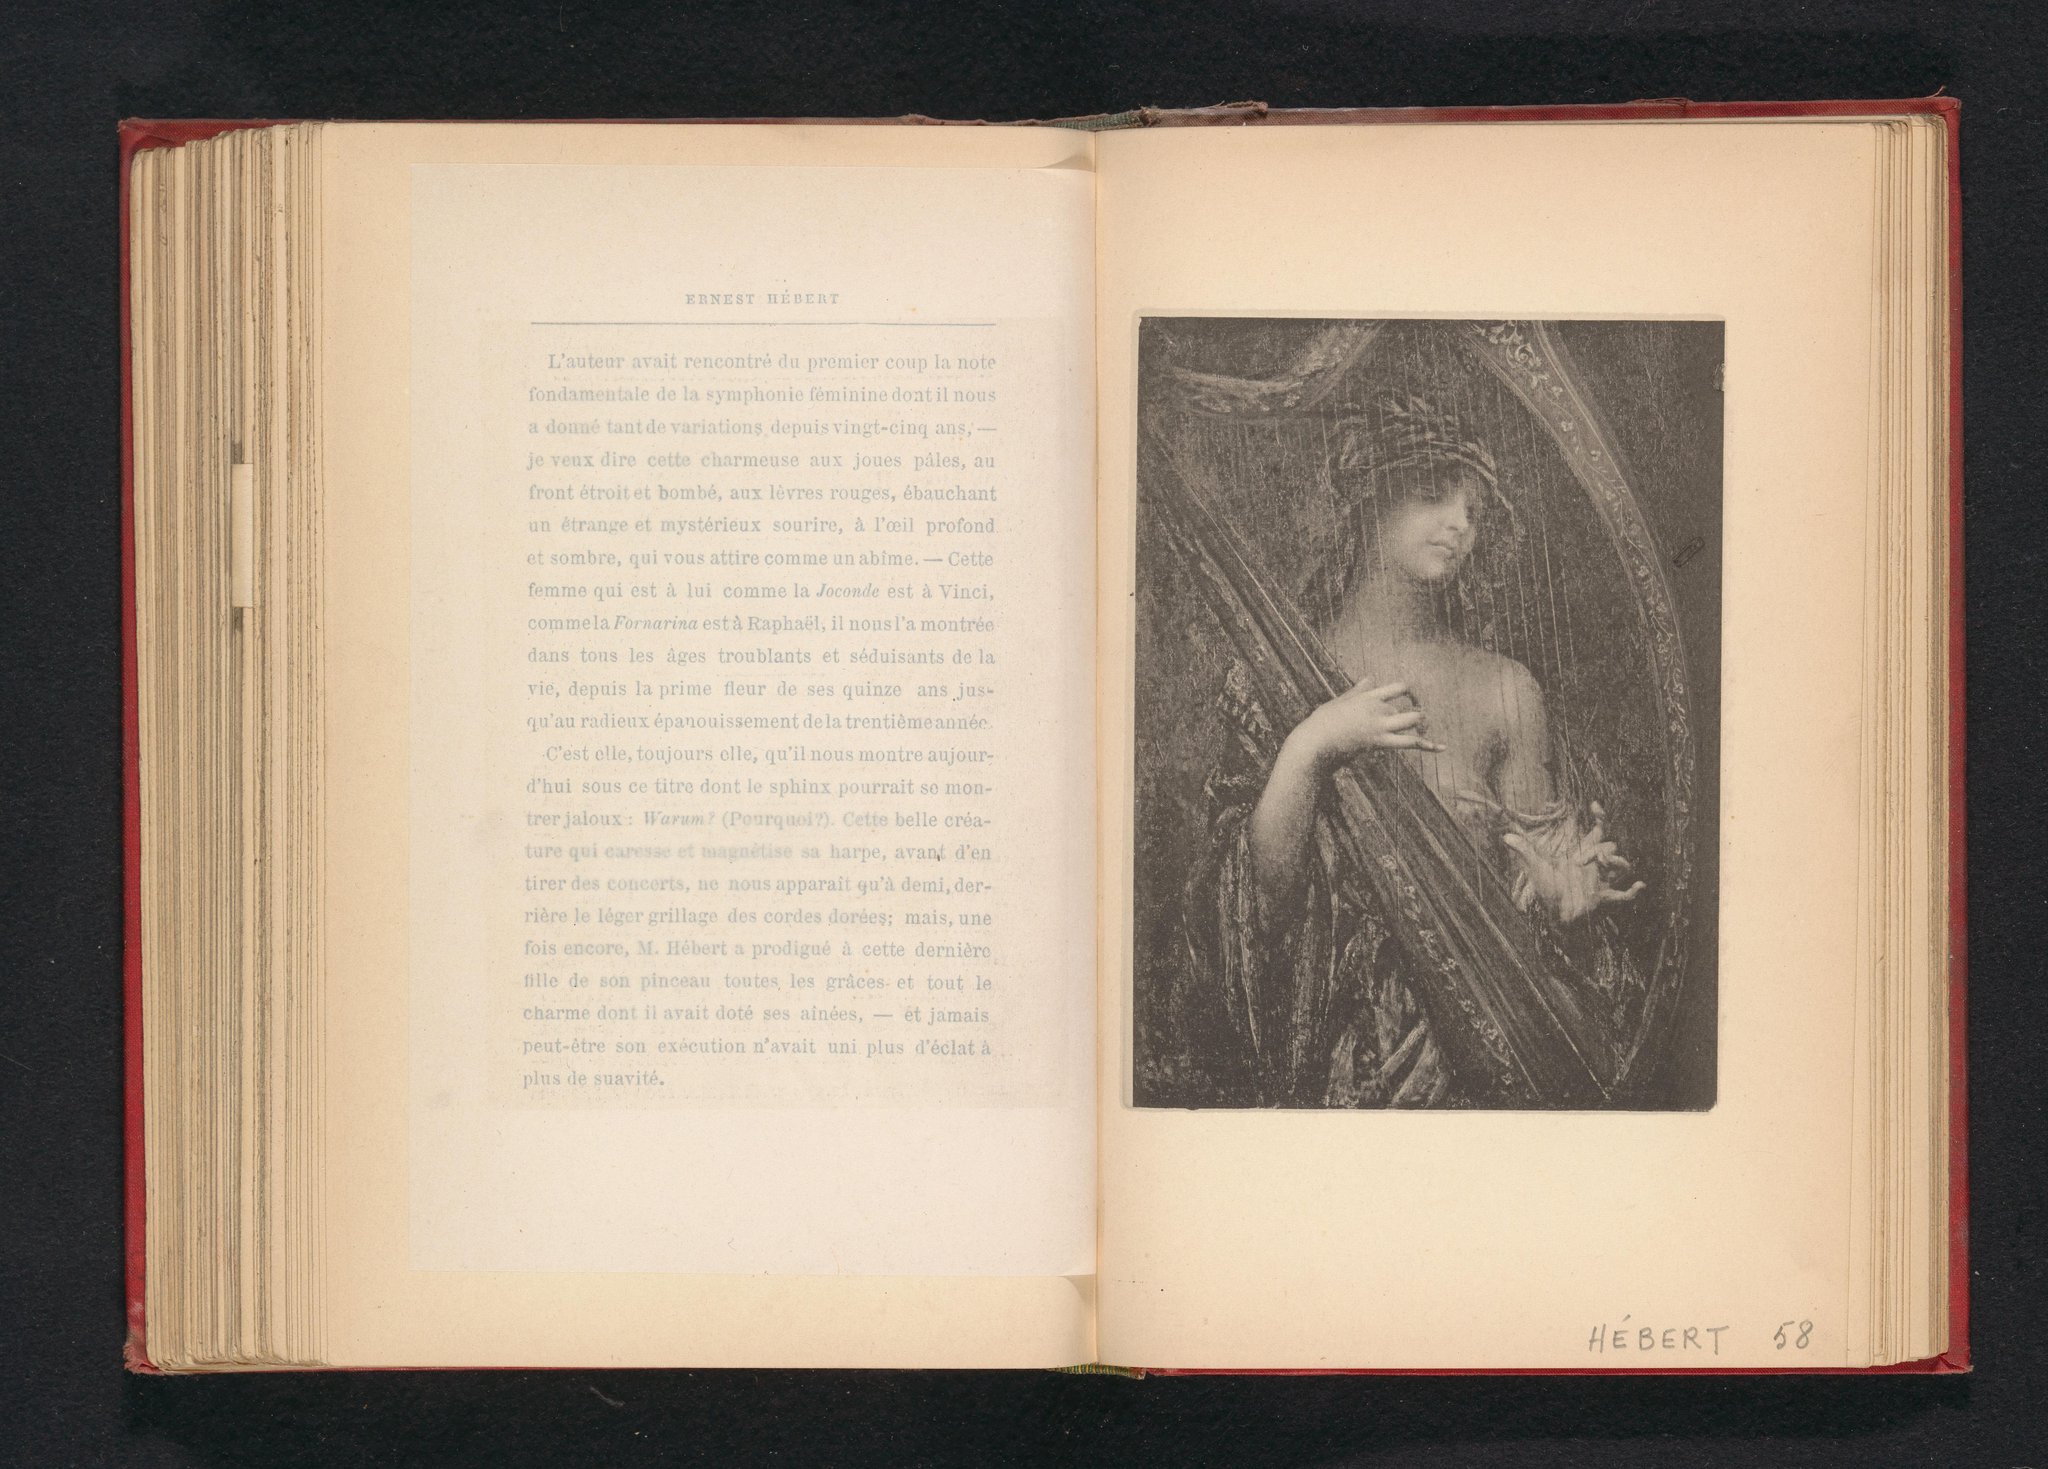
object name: photomechanical print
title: Fotoreproductie van een schilderij, voorstellende een vrouw met een harp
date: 1872-1882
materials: paper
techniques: photograph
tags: harp, one person playing string instrument (plucked)